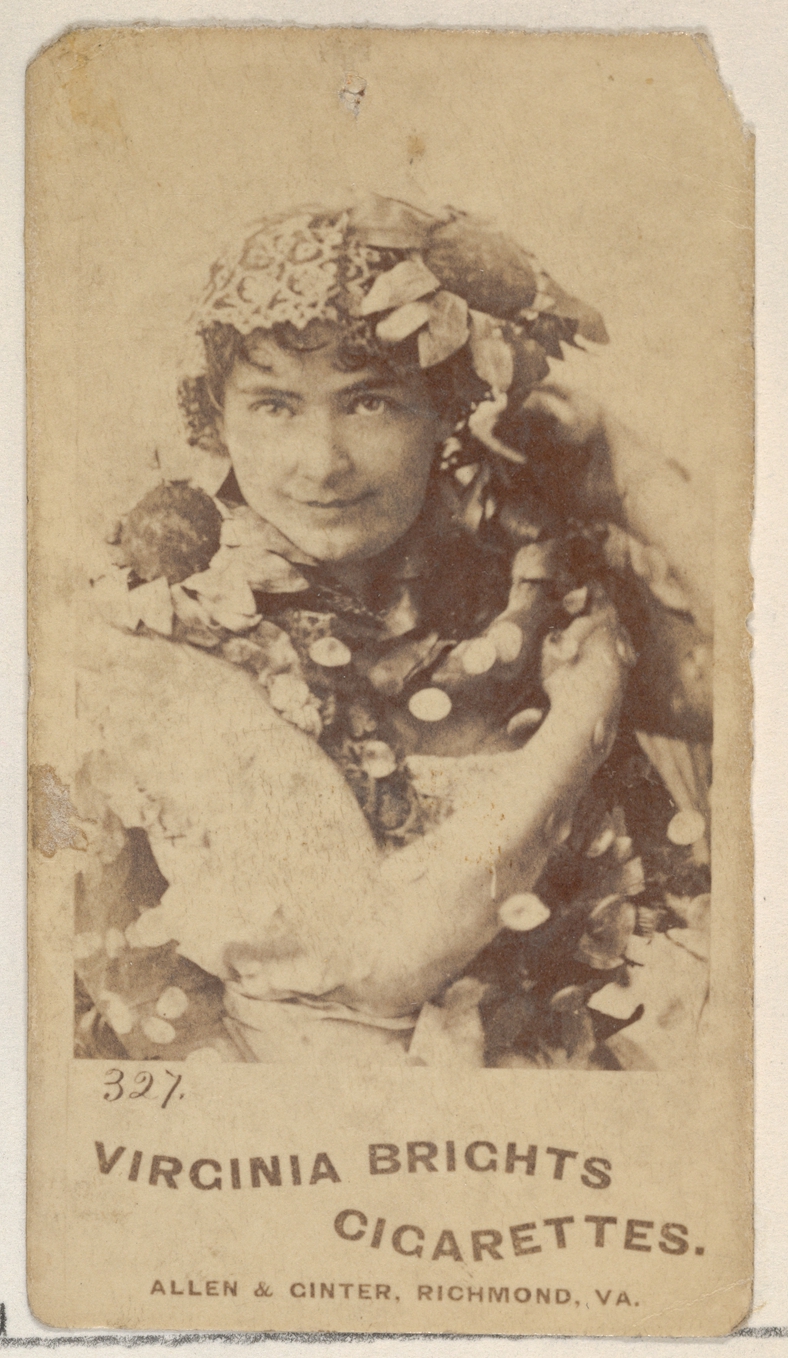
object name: photograph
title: Card 327, from the Actors and Actresses series (N45, Type 5) for Virginia Brights Cigarettes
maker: allen & ginter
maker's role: publisher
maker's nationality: american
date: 1888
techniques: albumen silver print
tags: portraits,women,actresses